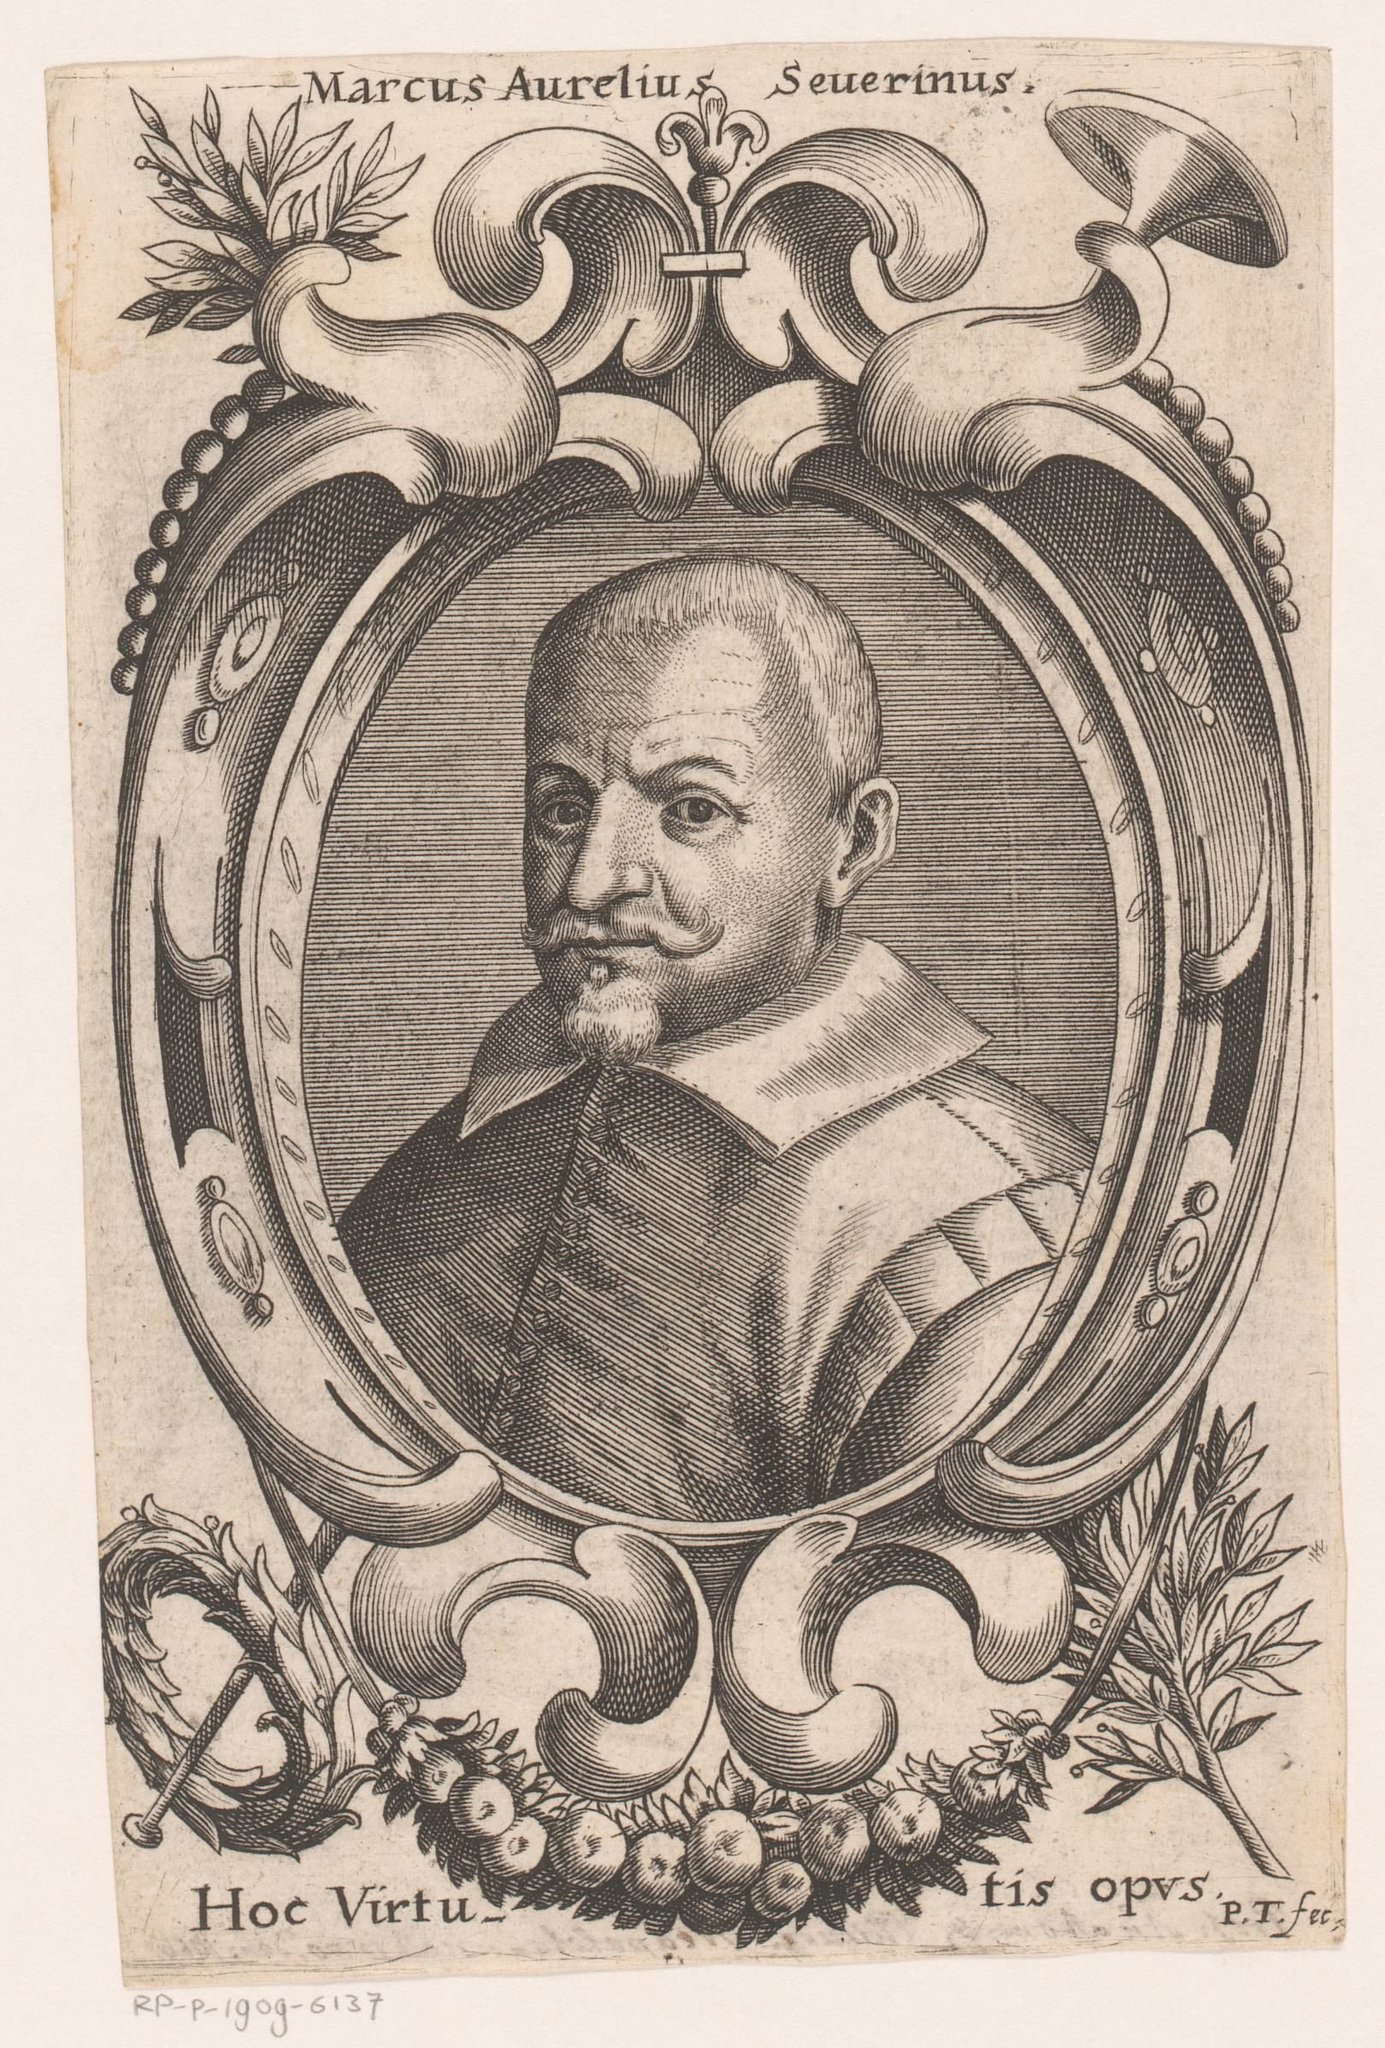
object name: print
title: Portret van Marco Aurelio Severino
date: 1630-1670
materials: paper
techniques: engraving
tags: cosenza, naples, fruits and vegetables ~ ornament, historical persons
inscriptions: inscription: ‘Prof: Anatom: & Chirurg. Neapolitan: nat 1580. den: 1656.’, collector's mark: Lugt 2228